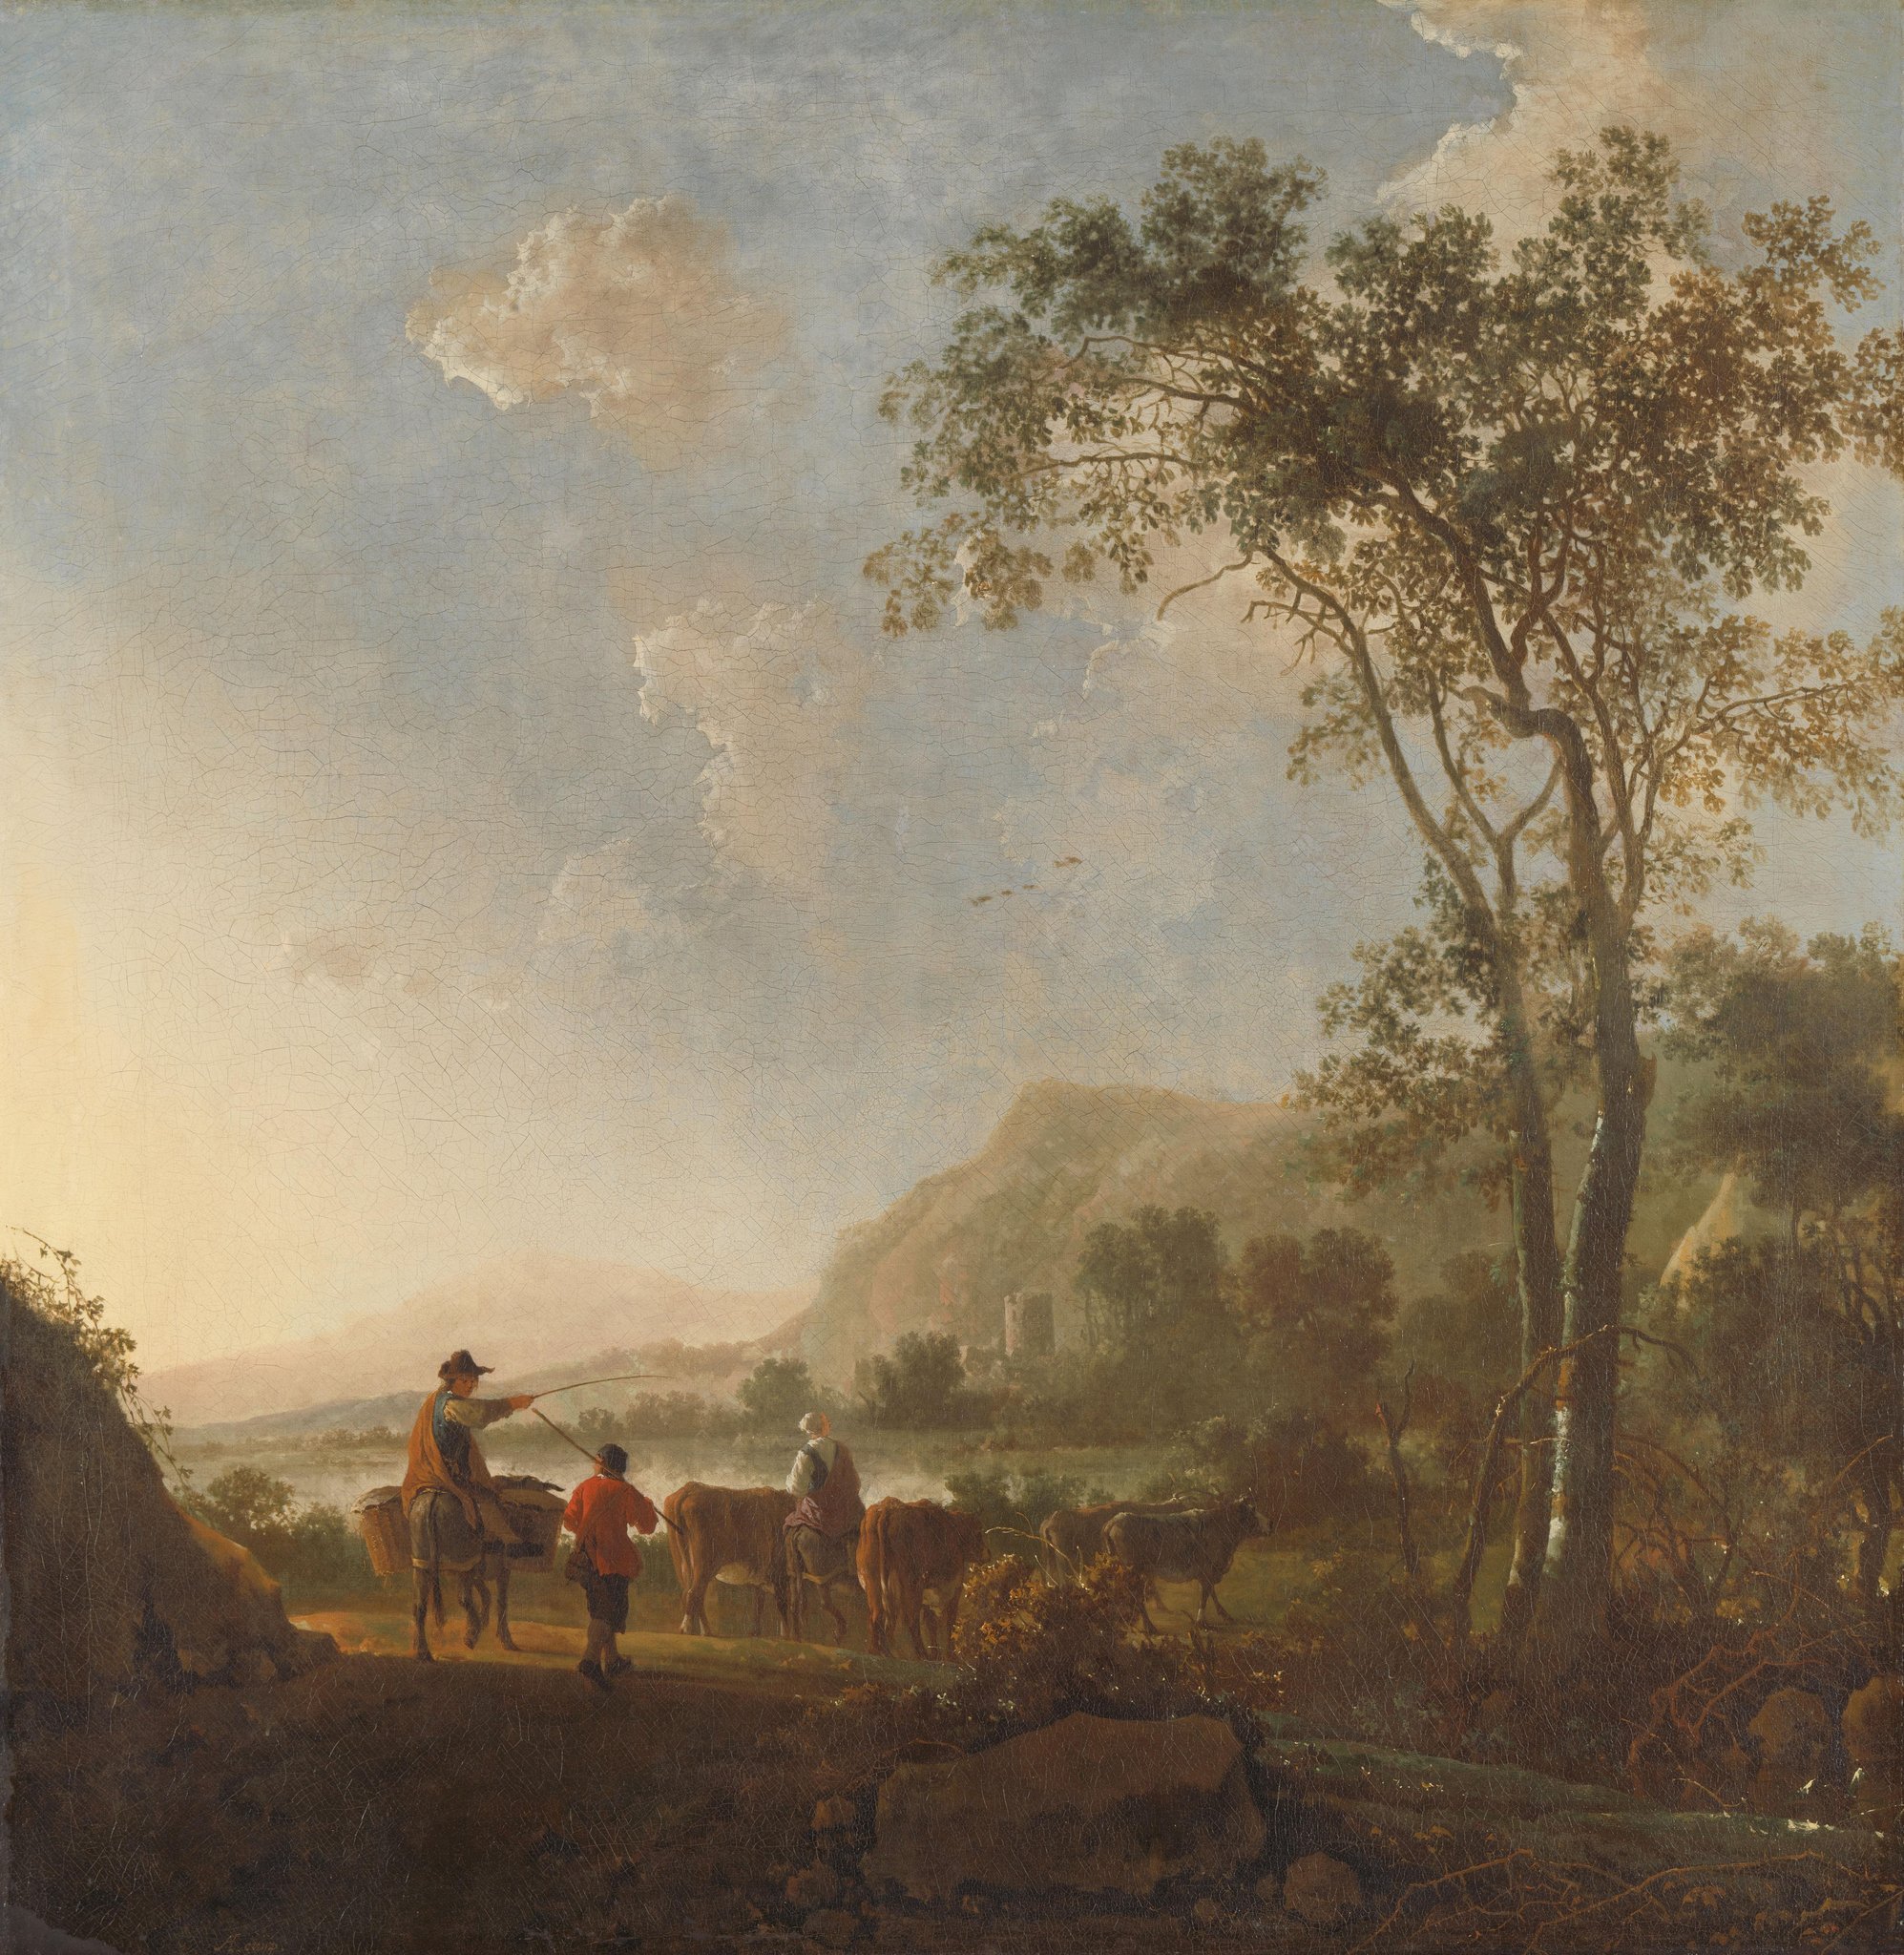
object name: painting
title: Landscape with Herdsmen and Cattle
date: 1660-1795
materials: canvas, oil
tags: herding, herdsman, herdswoman, shepherd, shepherdess, cowherd, etc., (high) hill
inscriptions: signature, bottom left (false): ‘A. cuijp.’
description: Aelbert Cuyp (1620 - 1691). Landscape with herdsmen and cattle, c. 1655. This landscape with its castle ruins evokes an idyllic atmosphere, reinforced by the contre jour effect. Cuyp never visited Italy, but many of his landscapes have a Mediterranean flavour, with mountains bathed in a golden sunlight. He was inspired by the work of Jan Both, who lived in Italy for a time and painted so-called Italianizing landscapes. Bequest of L. Dupper (Dordrecht), 1870.